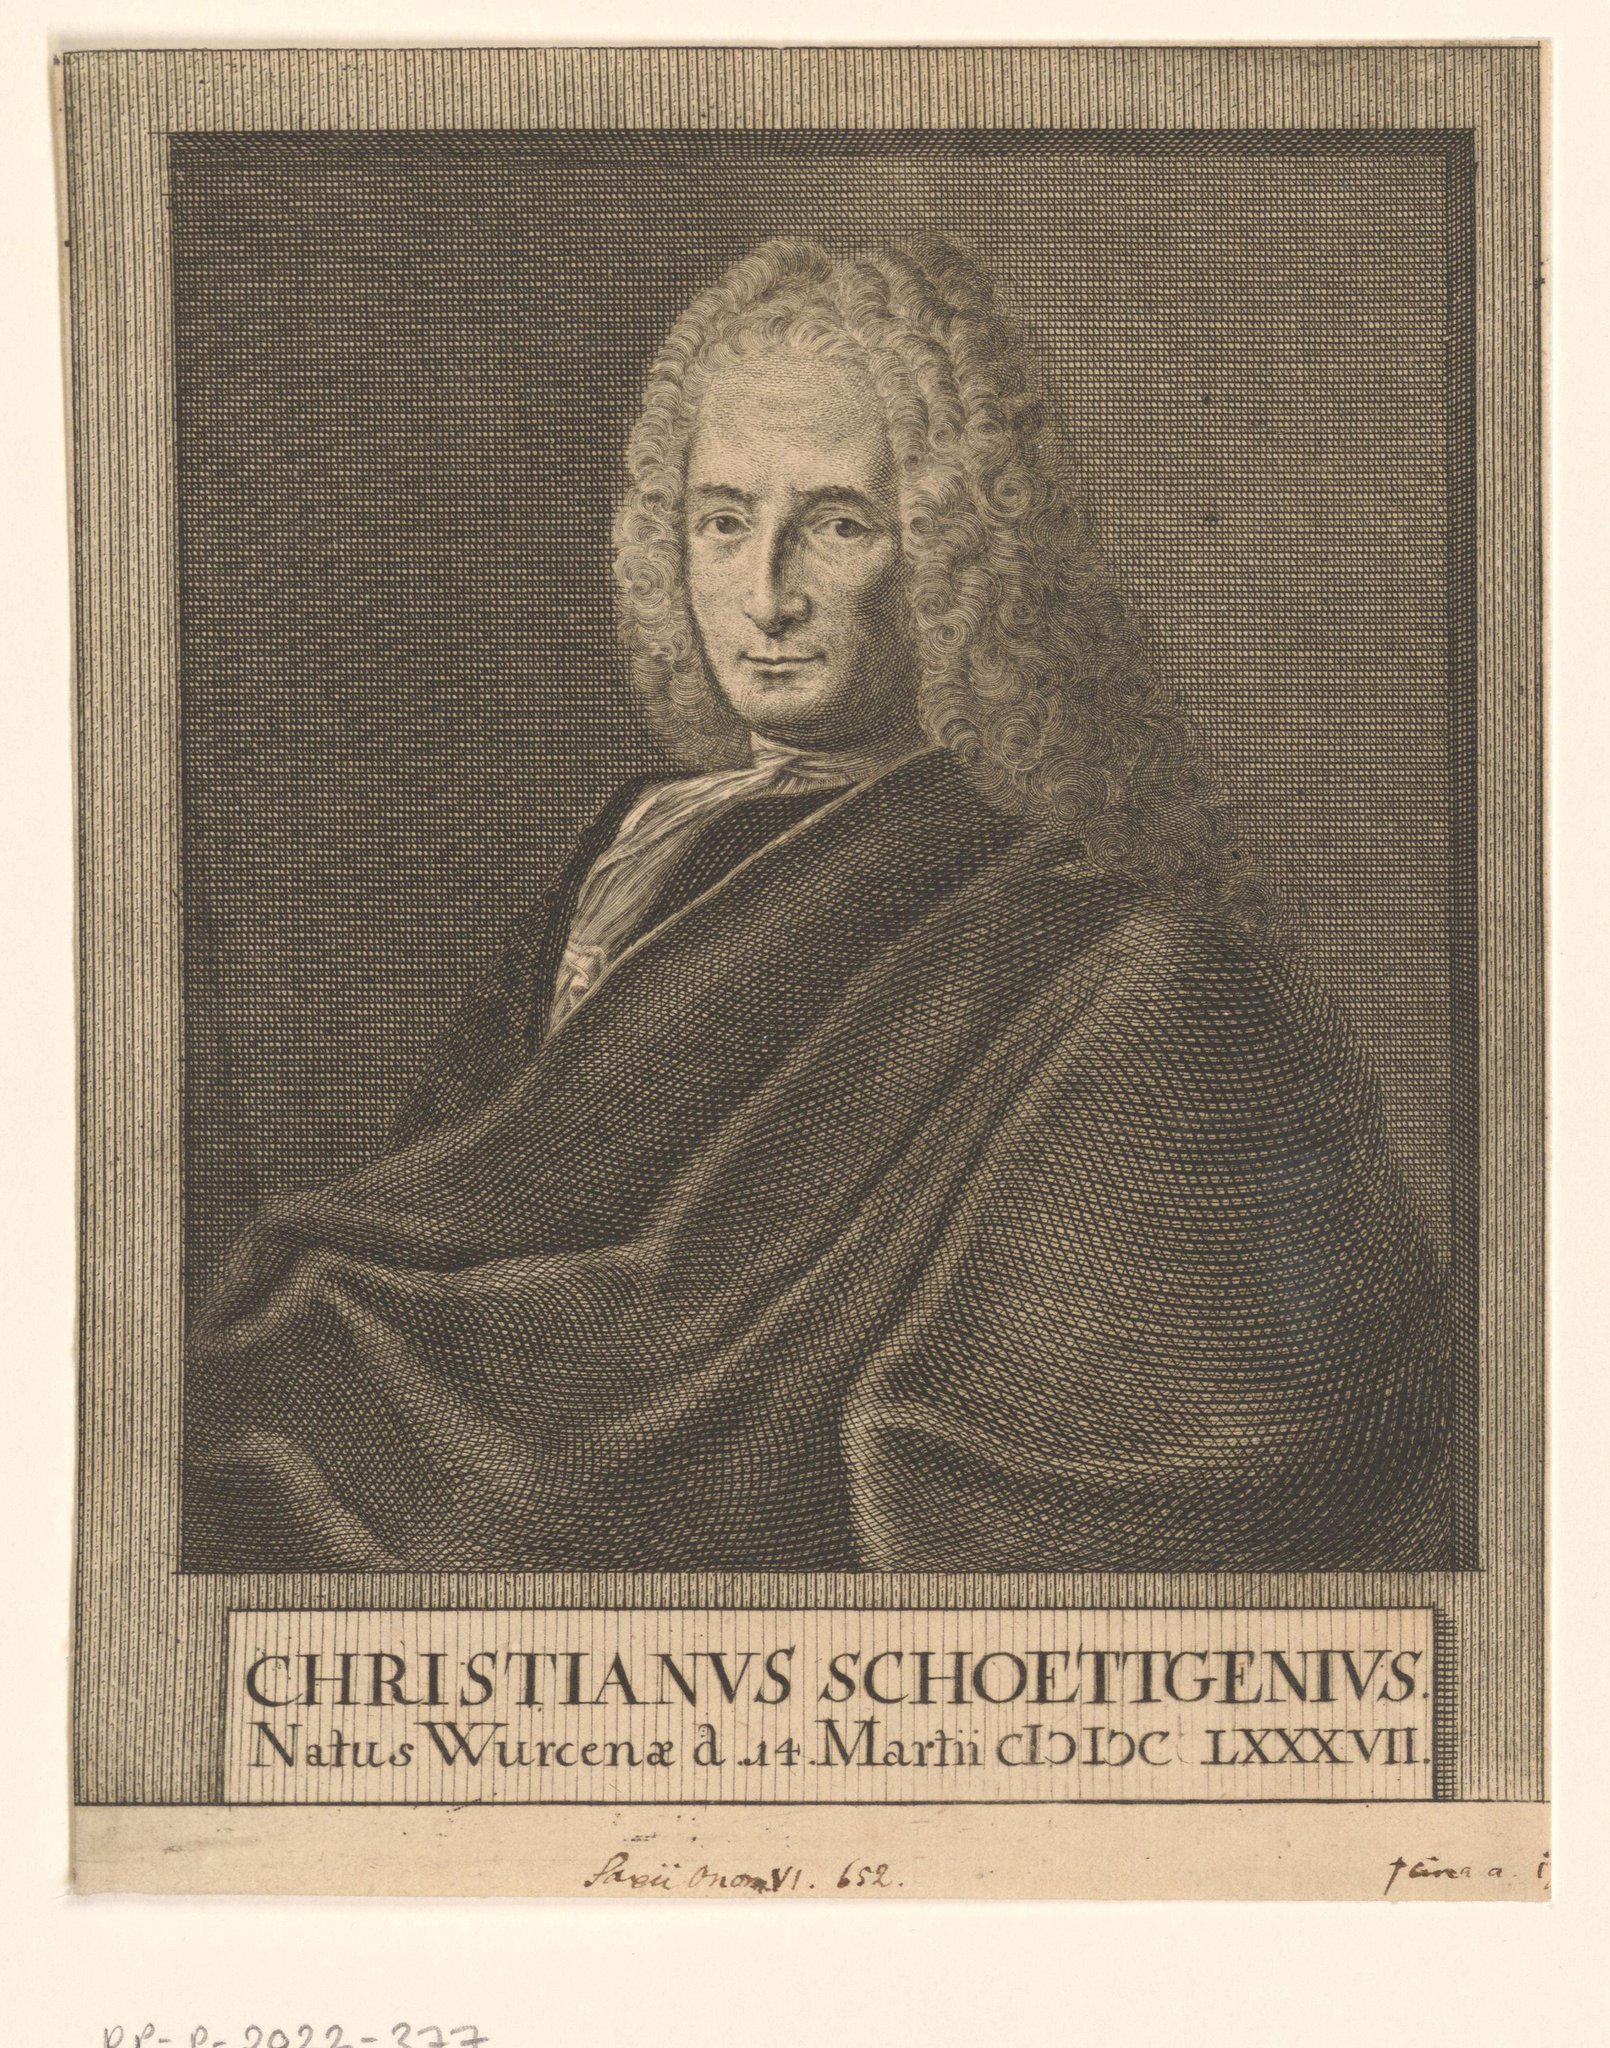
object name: print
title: Portret van Johann Christian Schöttgen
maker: Anonymous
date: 1700-1749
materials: paper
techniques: engraving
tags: scholar, philosopher, historical persons